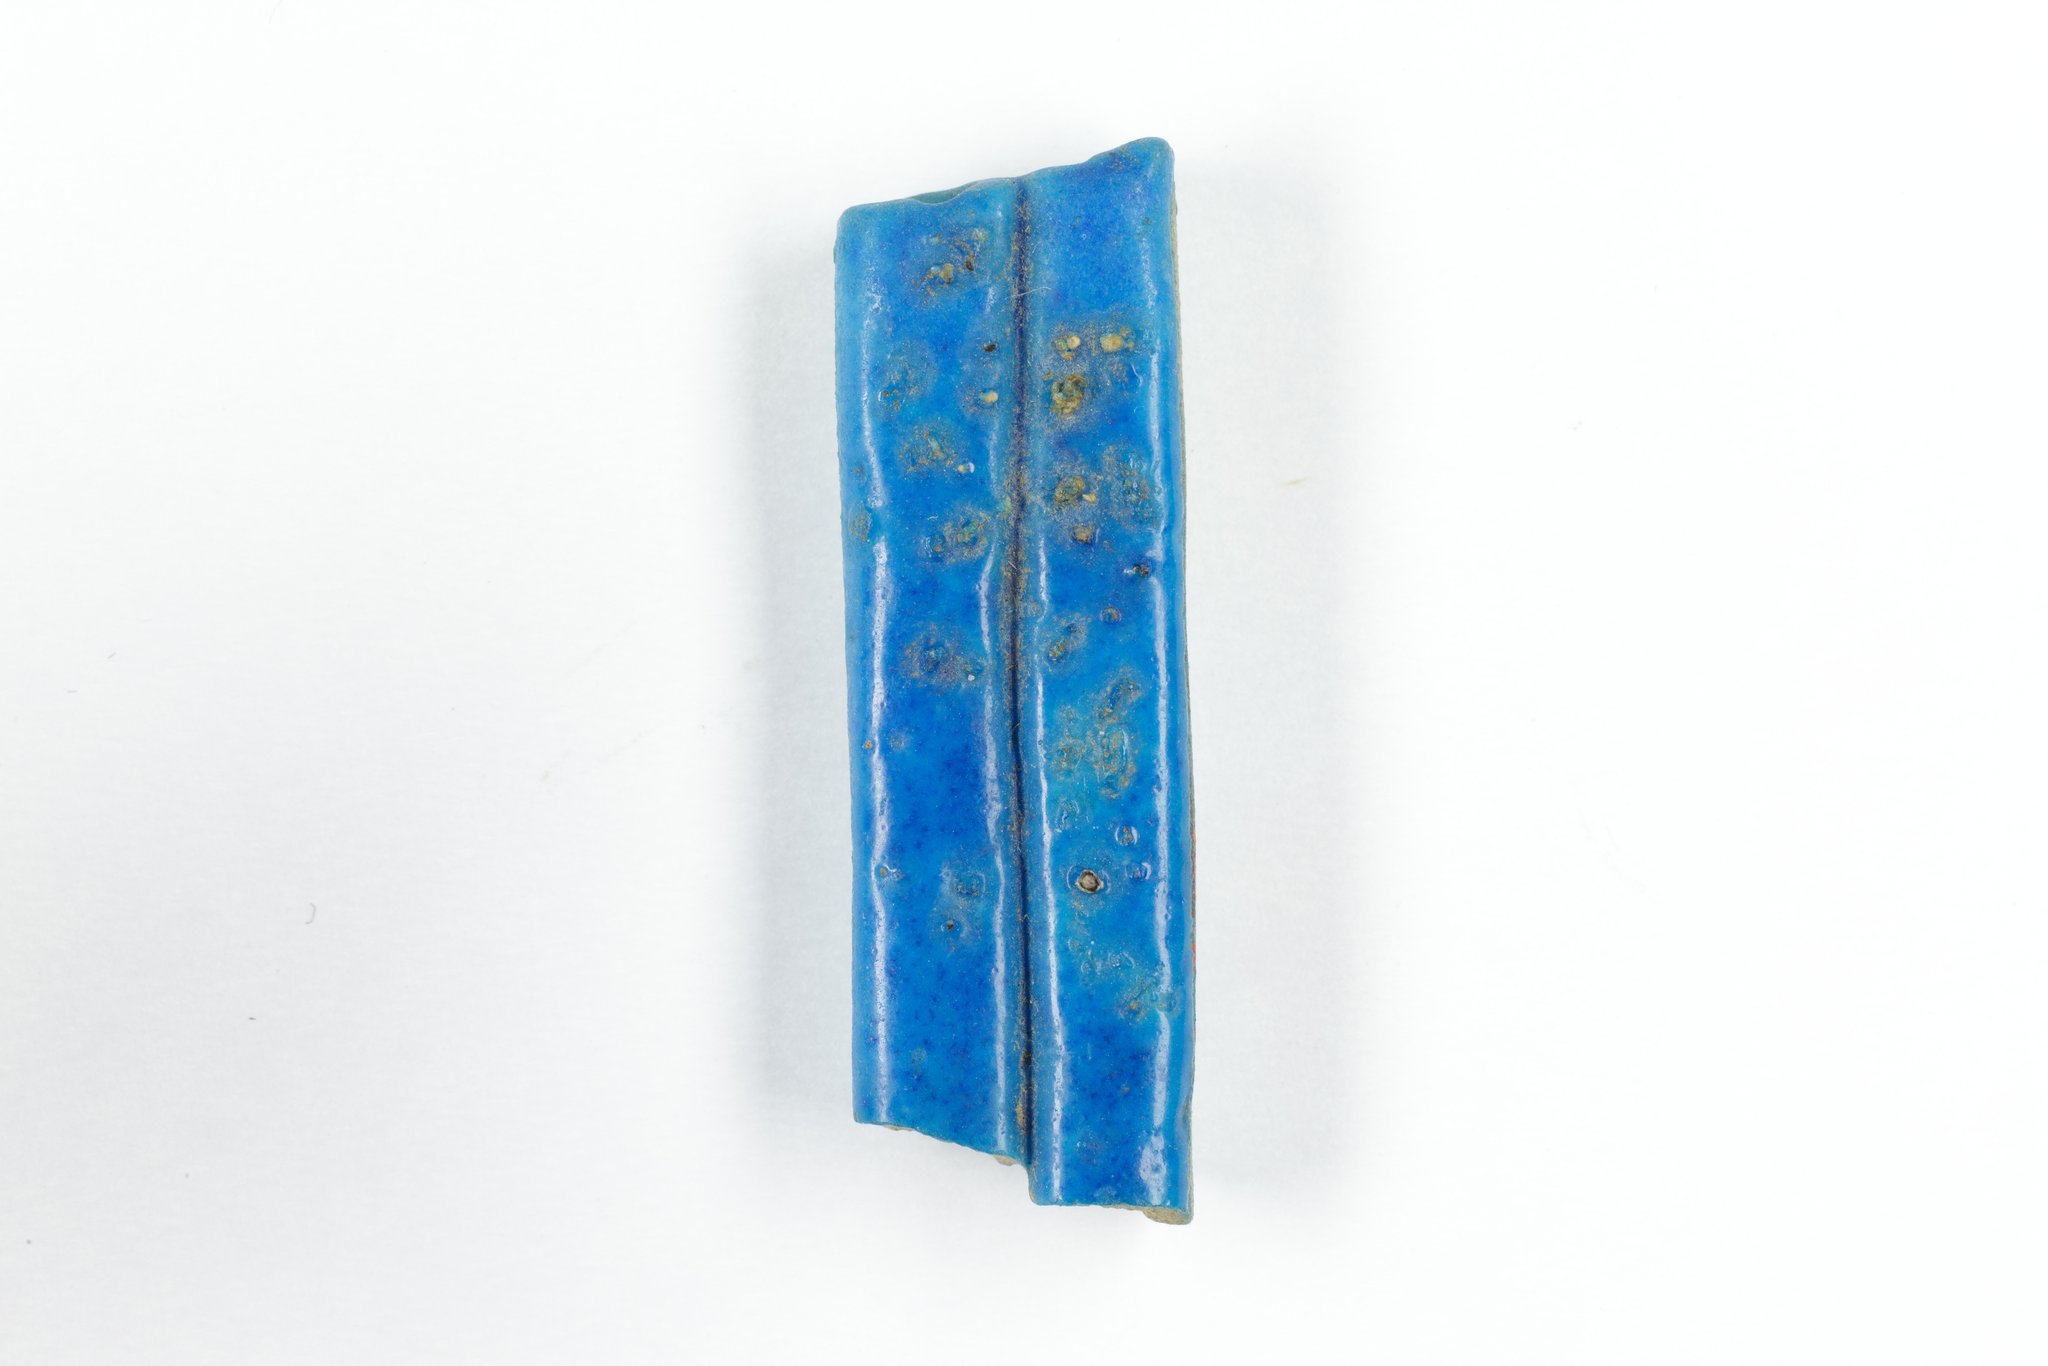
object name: bead, double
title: Double Bead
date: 1550-1295 BCE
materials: faience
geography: northern upper egypt